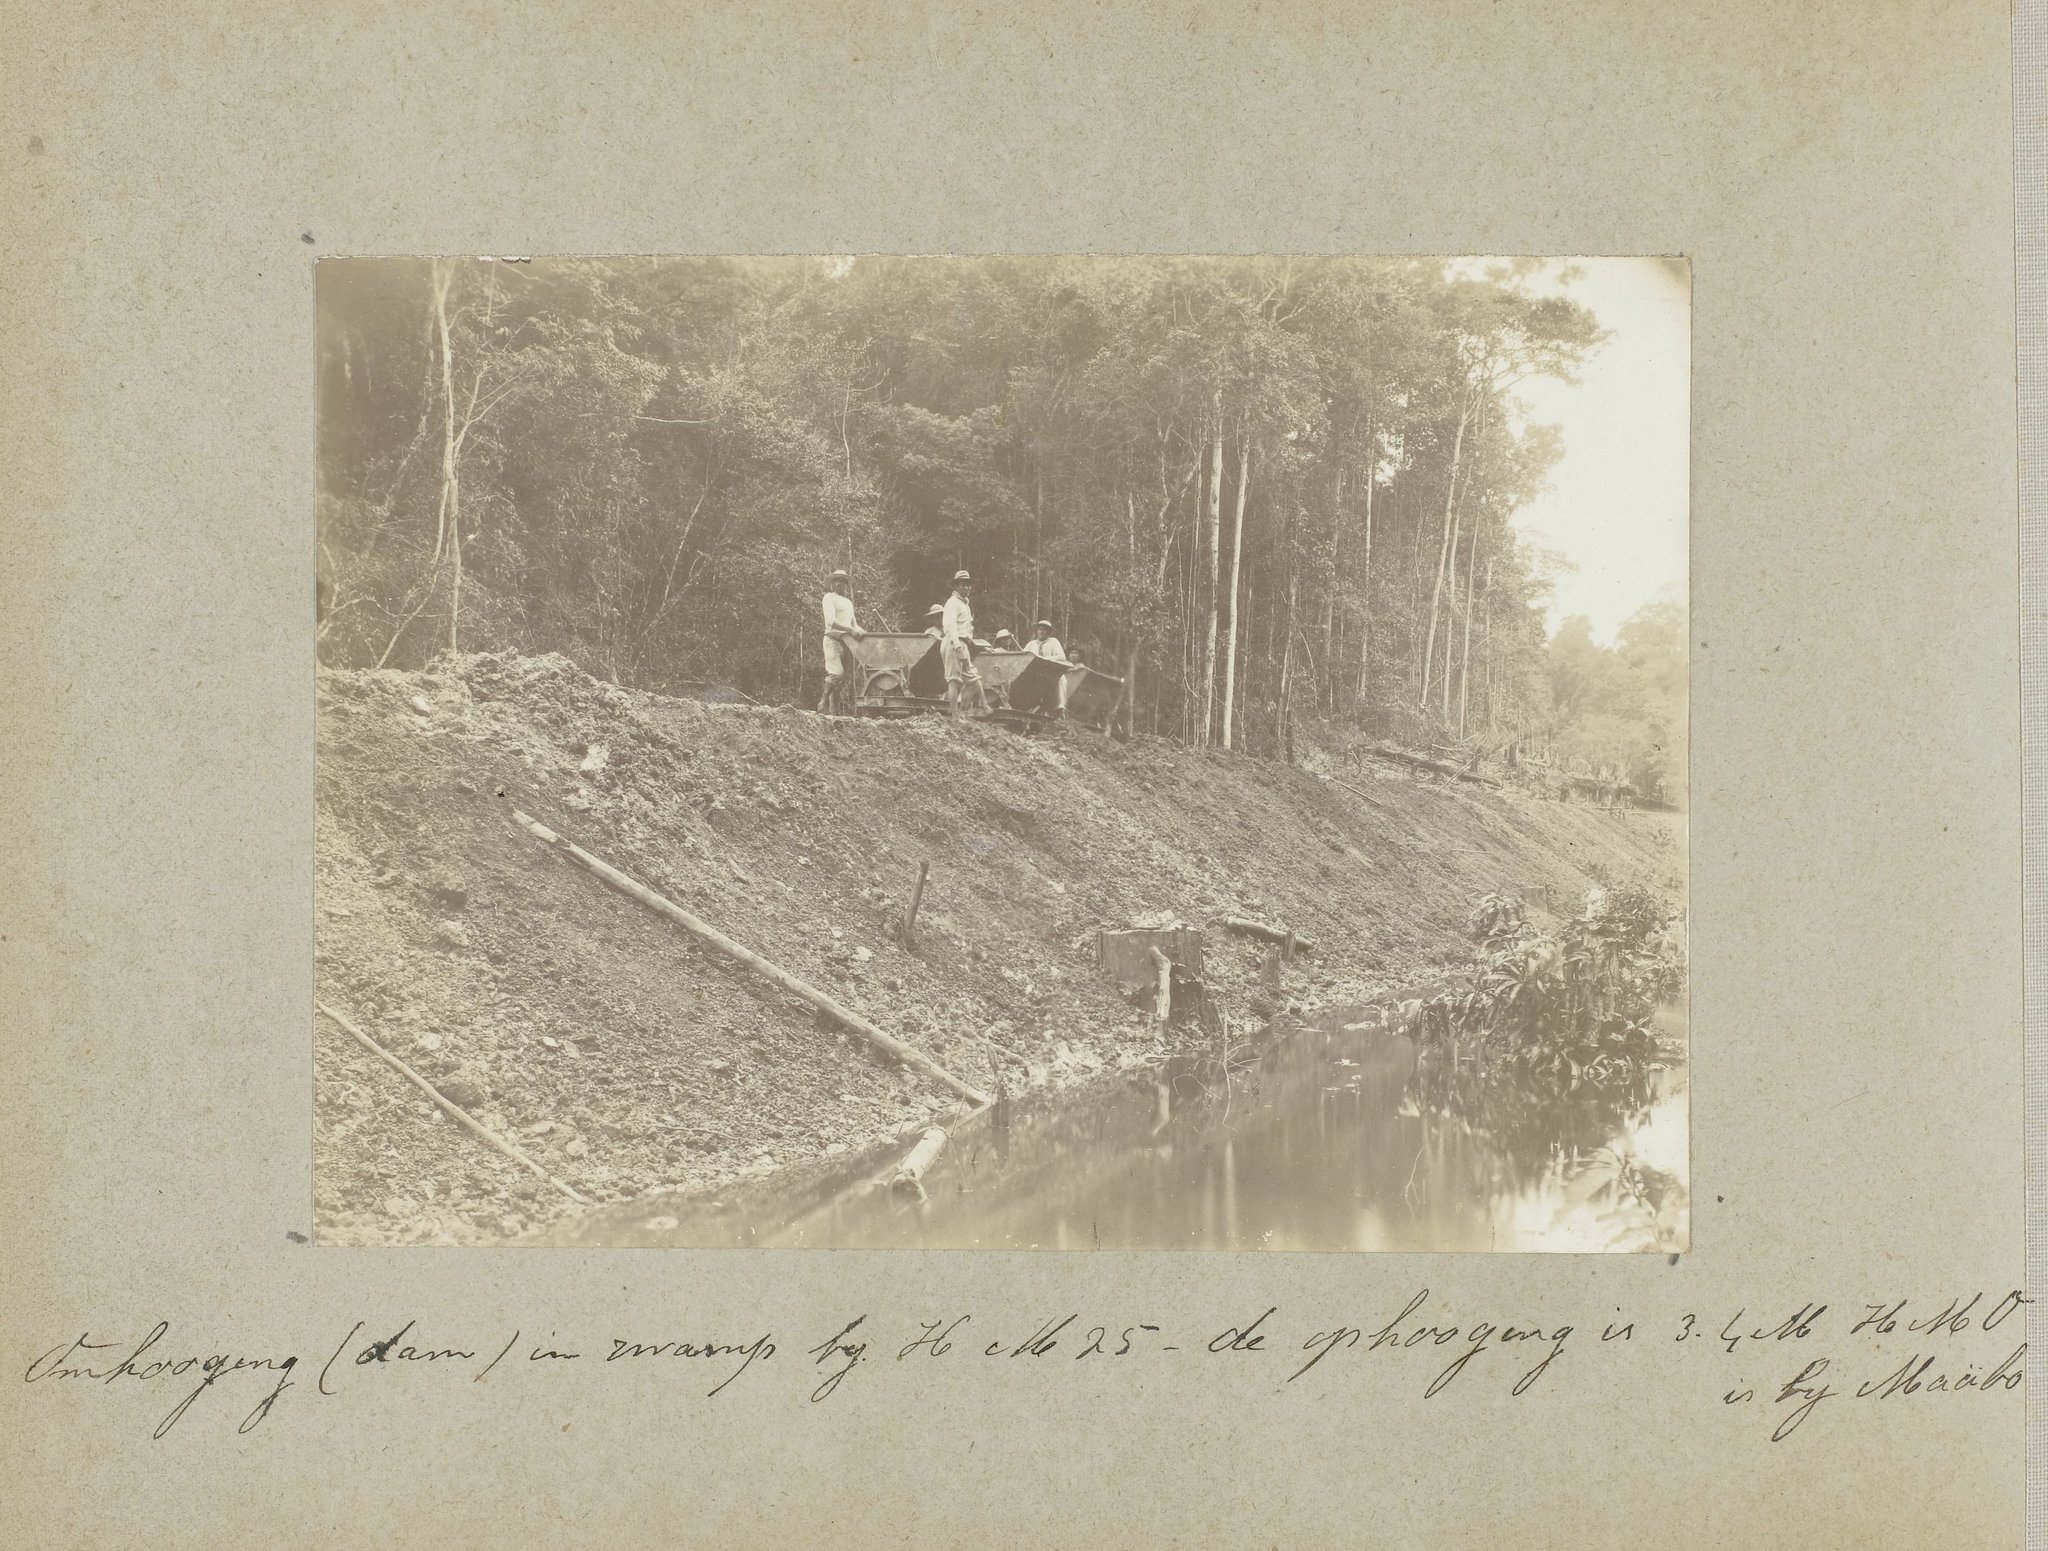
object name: photograph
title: Ophoging (dam) in zwamp ... bij Mäabo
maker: augusta curiel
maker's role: fotograaf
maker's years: 1873-1937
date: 1905-1910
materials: photographic support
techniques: photography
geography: suriname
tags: jacob evert wesenhagen, railway, tramway; rack railway, suriname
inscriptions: inscription: ‘Ophoging (dam) in zwamp bij H M 25 - de ophoging is 3.4 M H M O is bij Mäabo’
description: Ophoging van een dam aan de rand van een moeras, ten behoeve van de aanleg van de Lawaspoorweg. Foto in het fotoalbum over de aanleg van de Lawaspoorweg in Suriname in de jaren 1903-1912. Onderdeel van een groep objecten afkomstig van de familie Wesenhagen in Suriname.